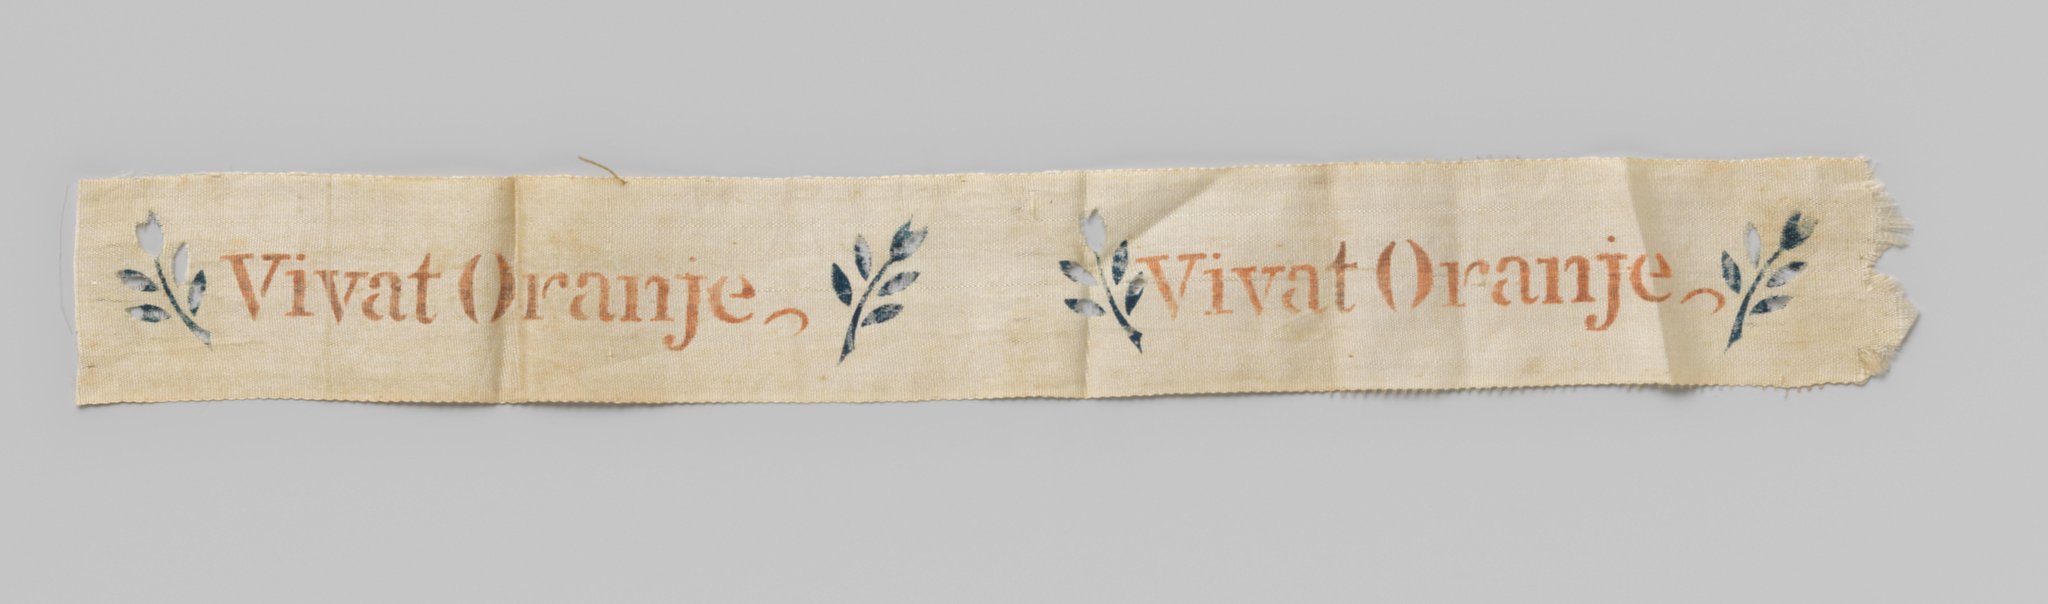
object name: ribbon material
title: Oranjelint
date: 1725-1750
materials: silk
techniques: printing, weave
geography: netherlands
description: Kleine lint met tweemaal het opschrift tussen twee takjes. Opschrift: VIVAT ORANJE.